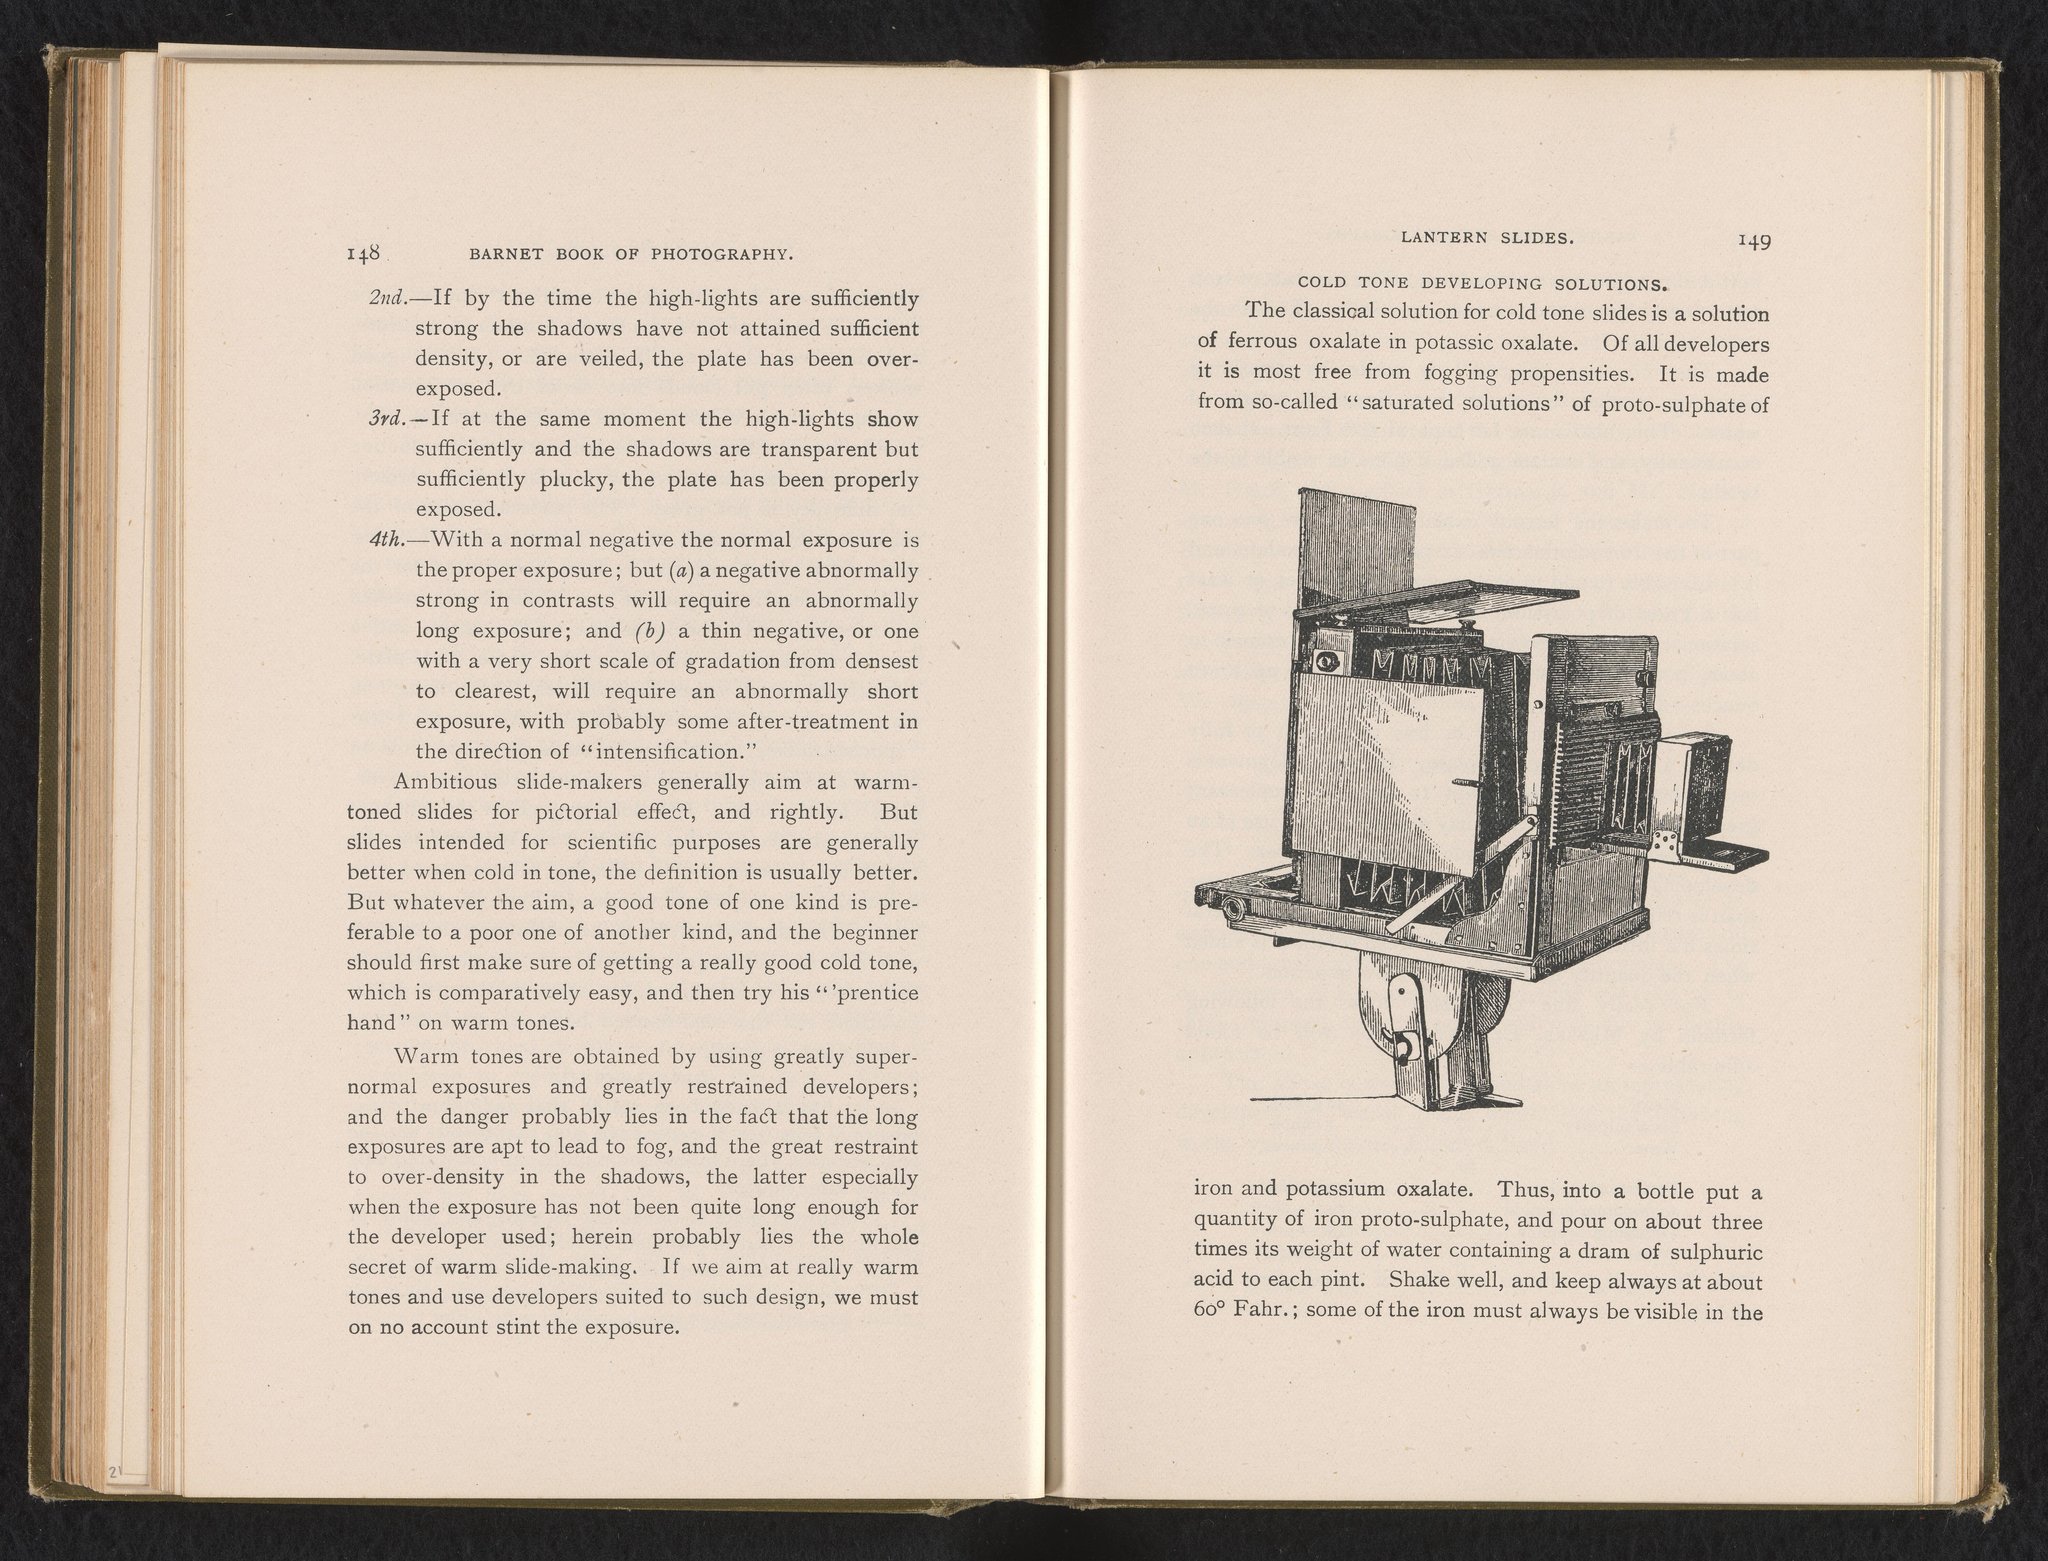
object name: page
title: Camera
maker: Anonymous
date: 1895-1900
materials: paper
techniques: letterpress printing, line block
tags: camera ~ photography